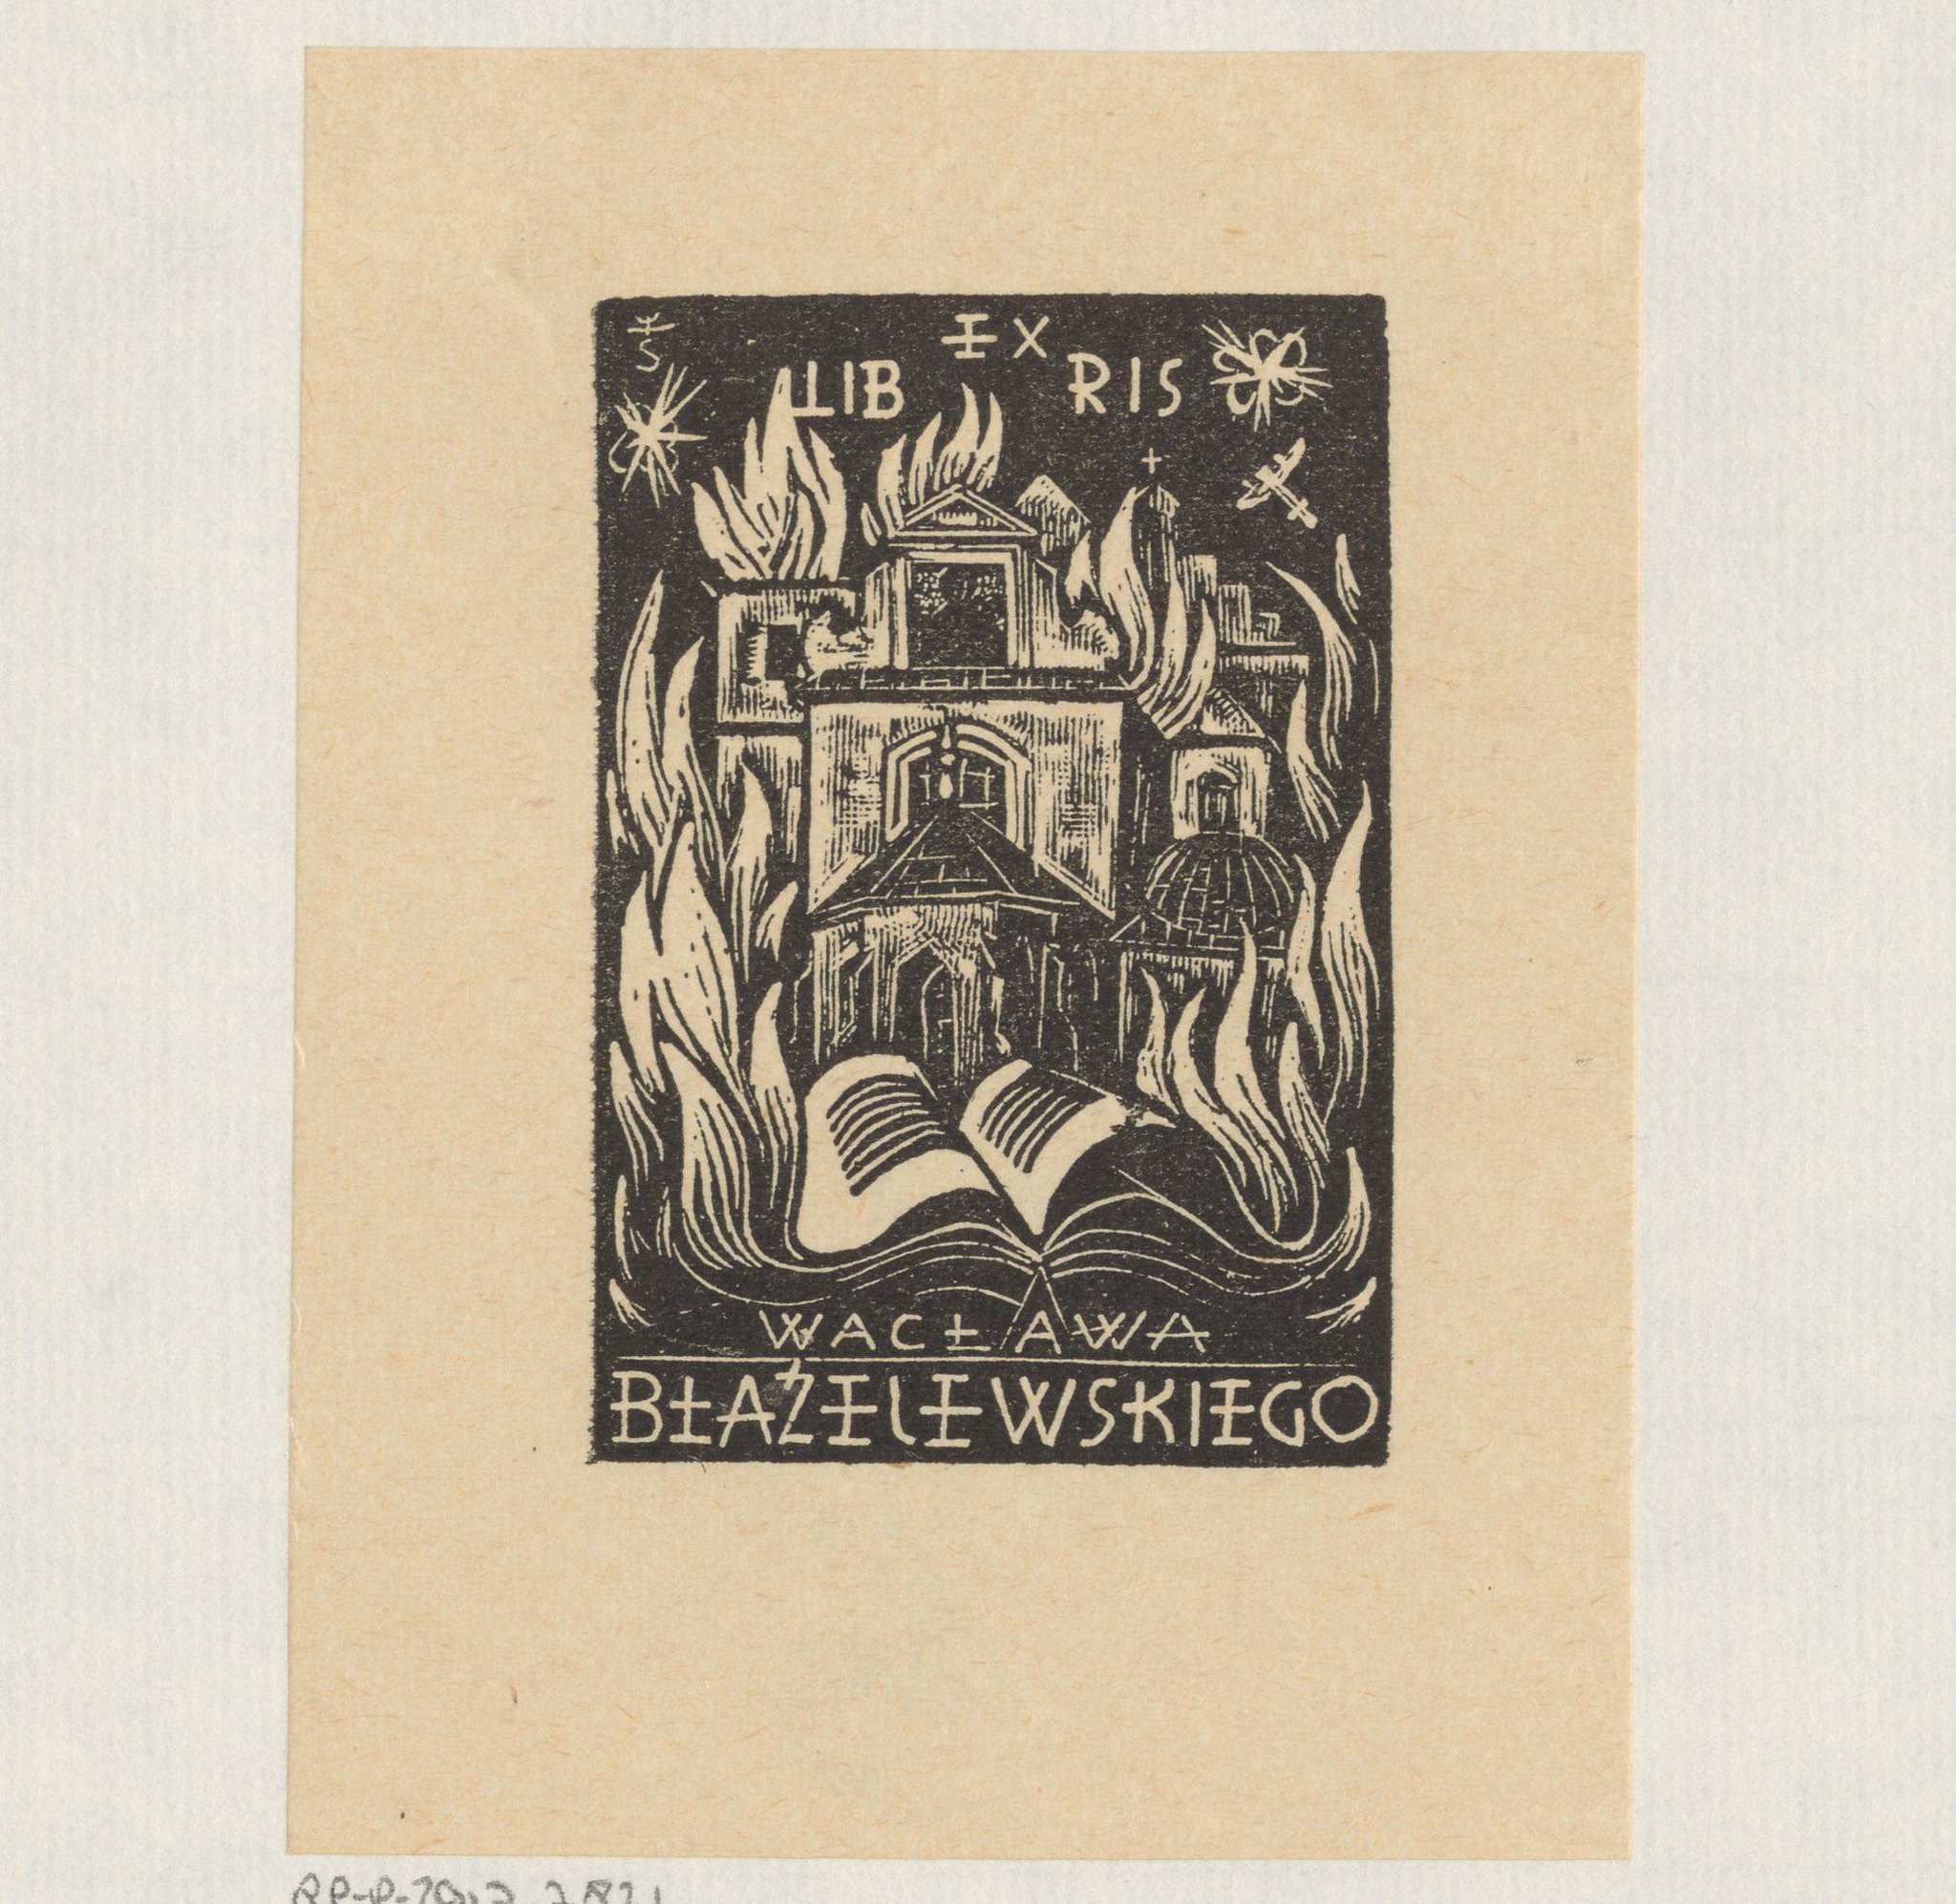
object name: bookplate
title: Ex libris van Wacław Błażejewski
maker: tadeusz cieślewski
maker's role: print maker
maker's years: 1895-1944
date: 1912-1944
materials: paper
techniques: woodcut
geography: poland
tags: publisher, housing, book, war, flame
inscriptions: recto, handgeschreven